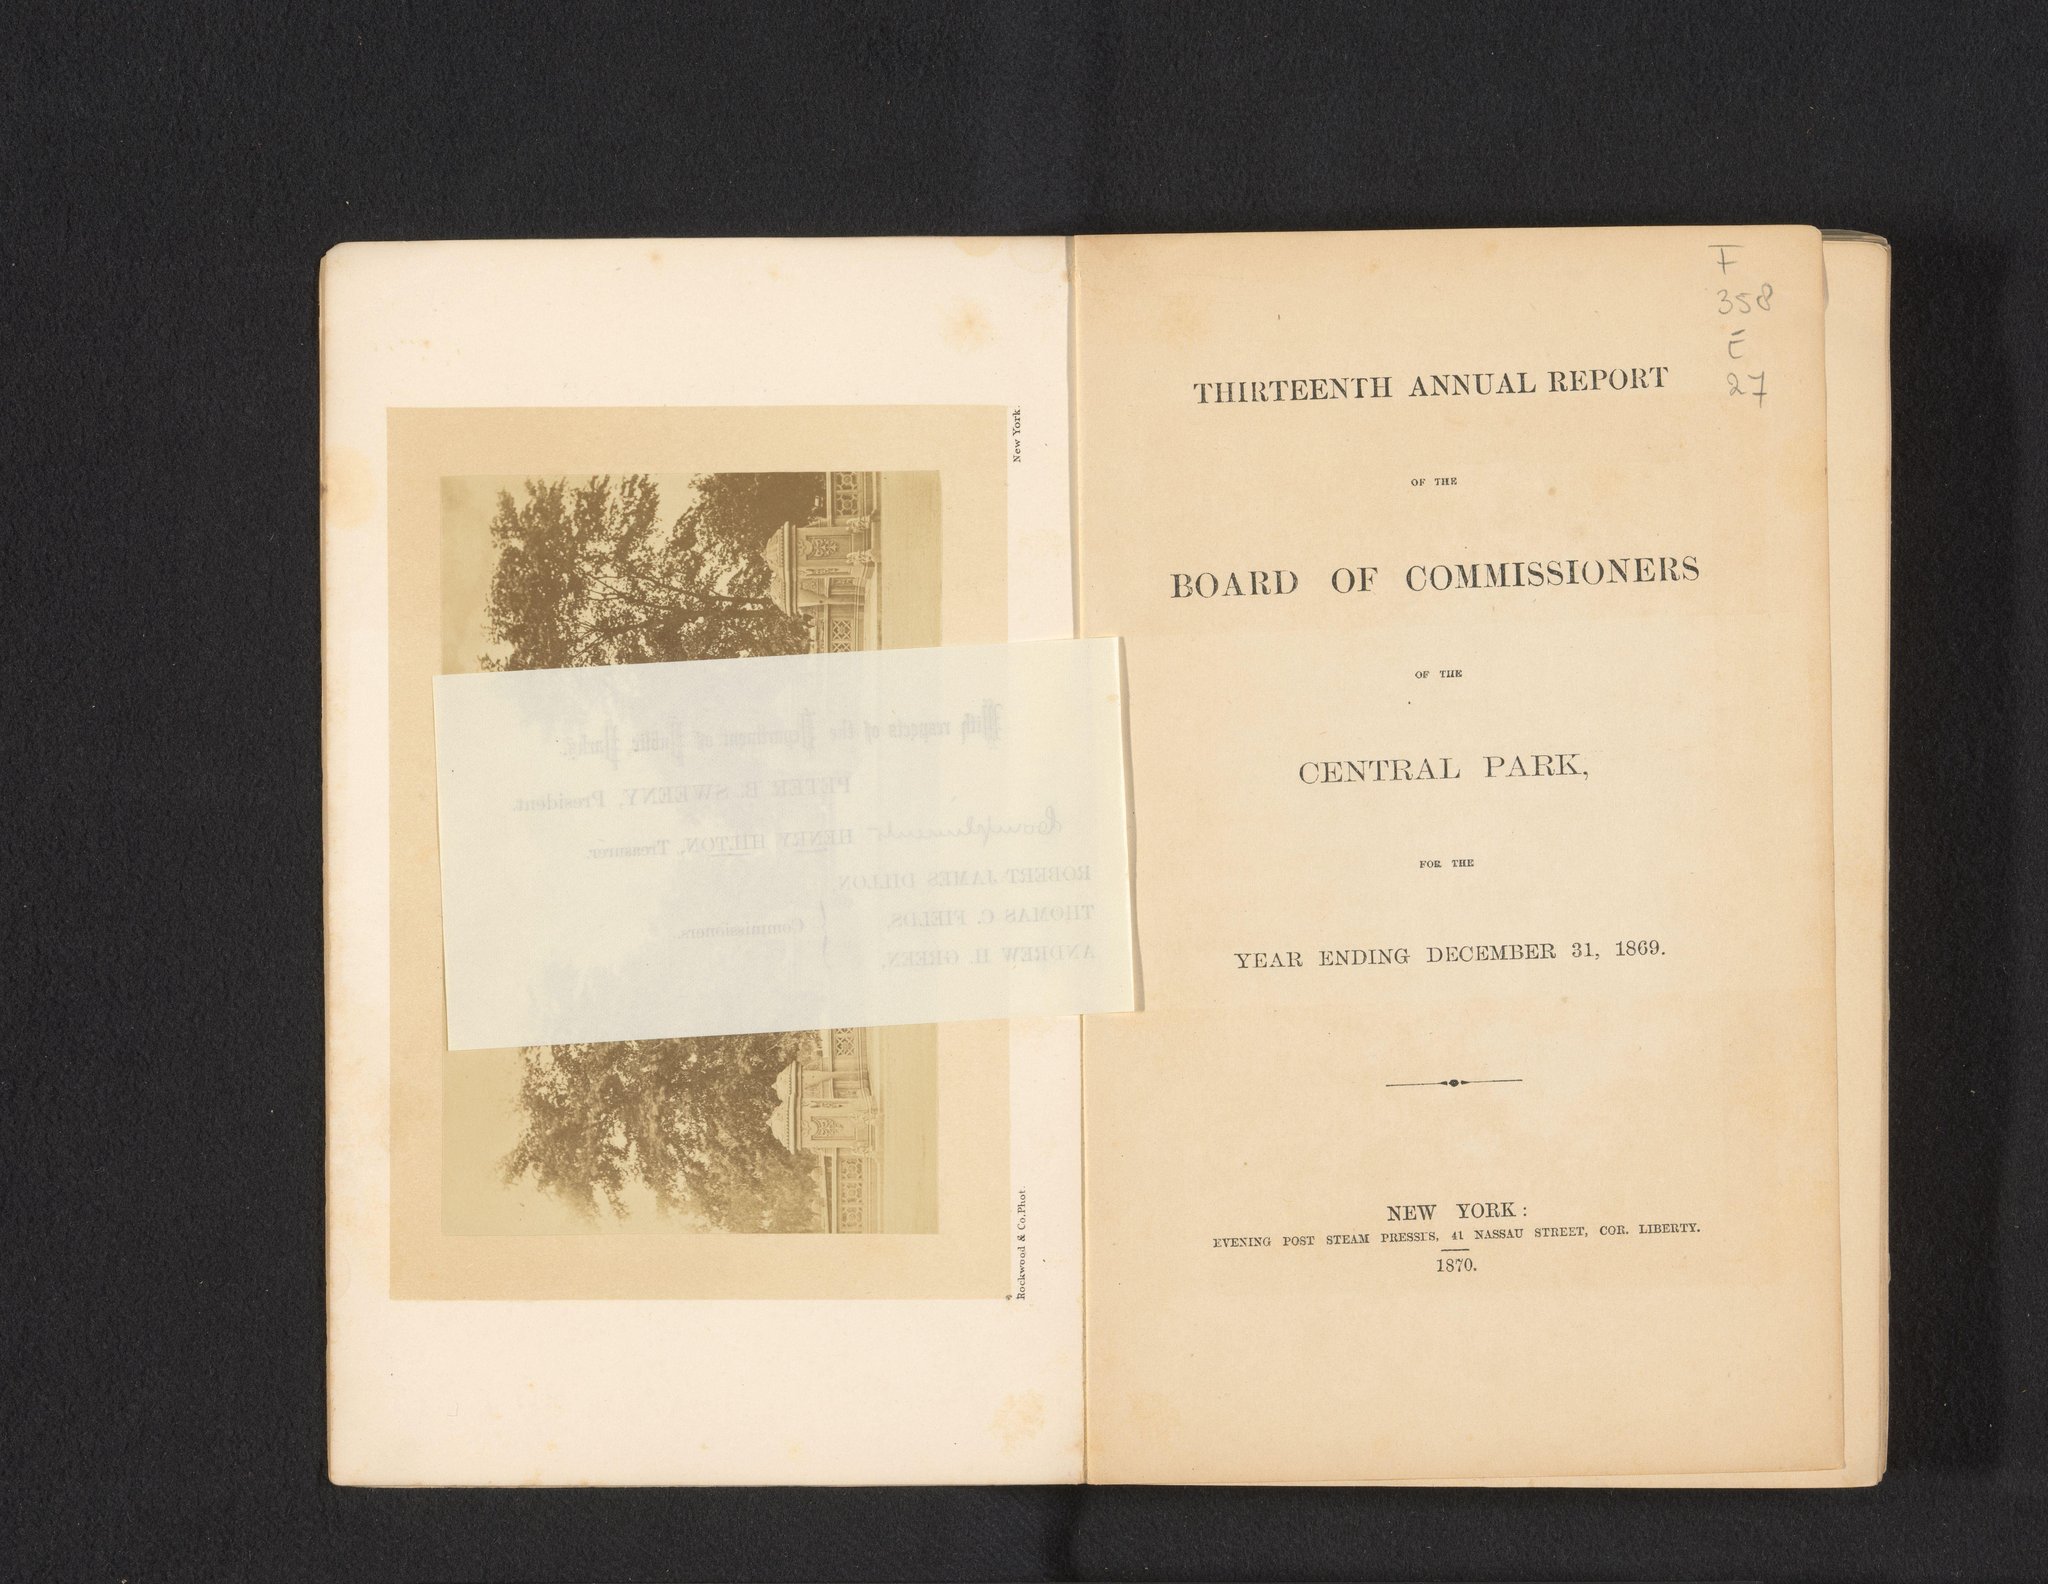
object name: book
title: Annual report of the Board of Commissioners of the Central Park for the year ending December 31, 1869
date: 1870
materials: paper, photographic support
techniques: albumen print, lithograph, printing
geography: new york city